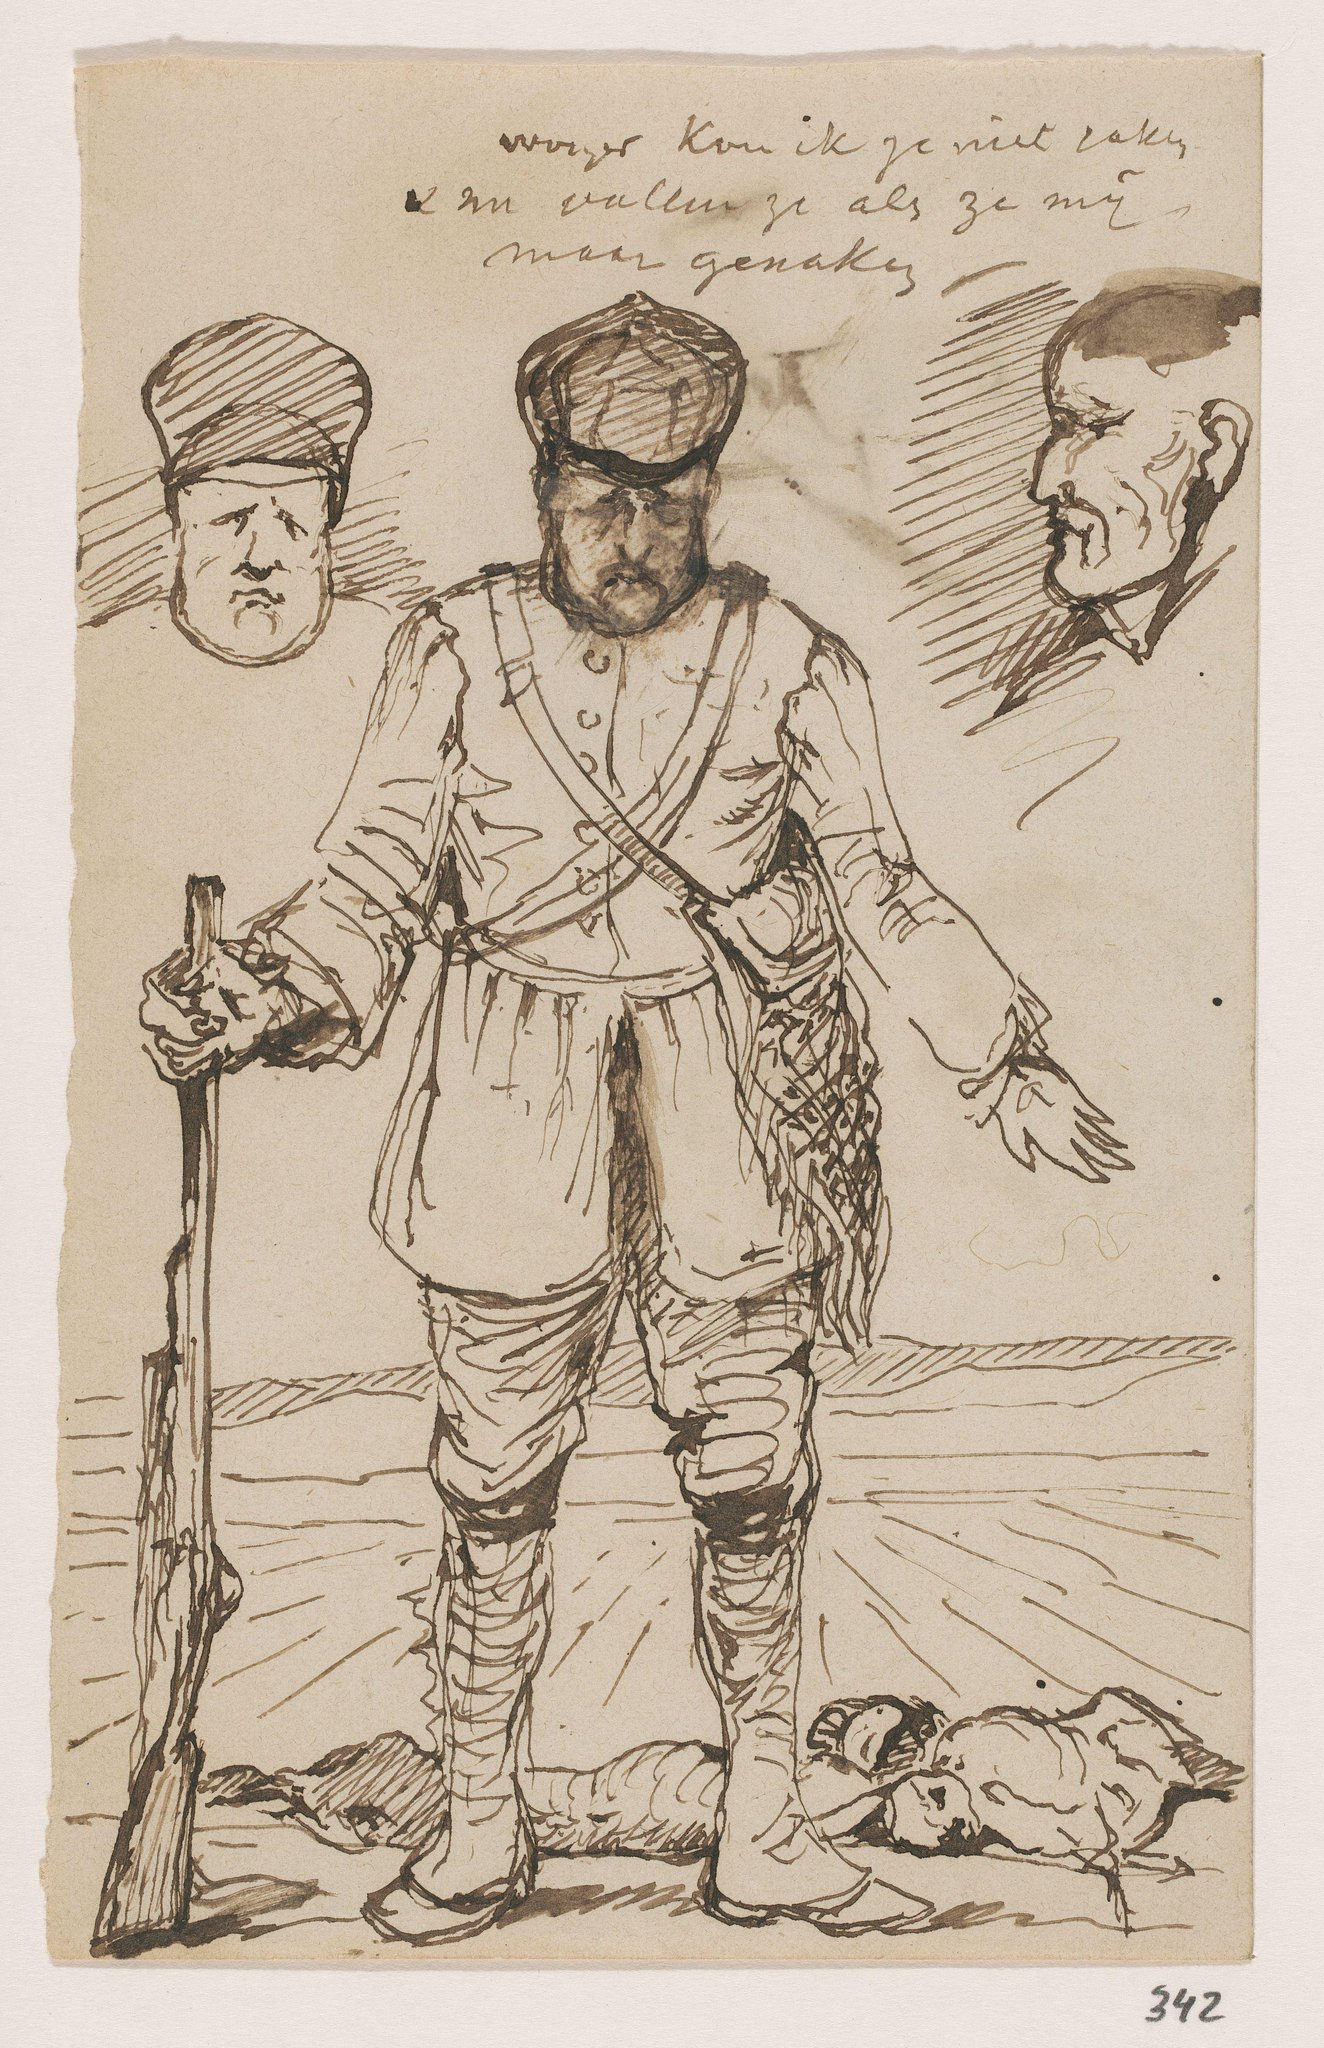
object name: drawing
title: Jager met hazen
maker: johannes tavenraat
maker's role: draughtsman, painter, print maker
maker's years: 1809-1881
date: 1840-1880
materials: ink, paper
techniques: brush, pen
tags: rodents: hare, hare-hunting, rabbit-hunting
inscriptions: annotation: ‘vroeger kon ik ze niet raken / & nu vallen ze als ze mij maar genaken’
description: Jager staande bij een veld met enkele geschoten hazen.